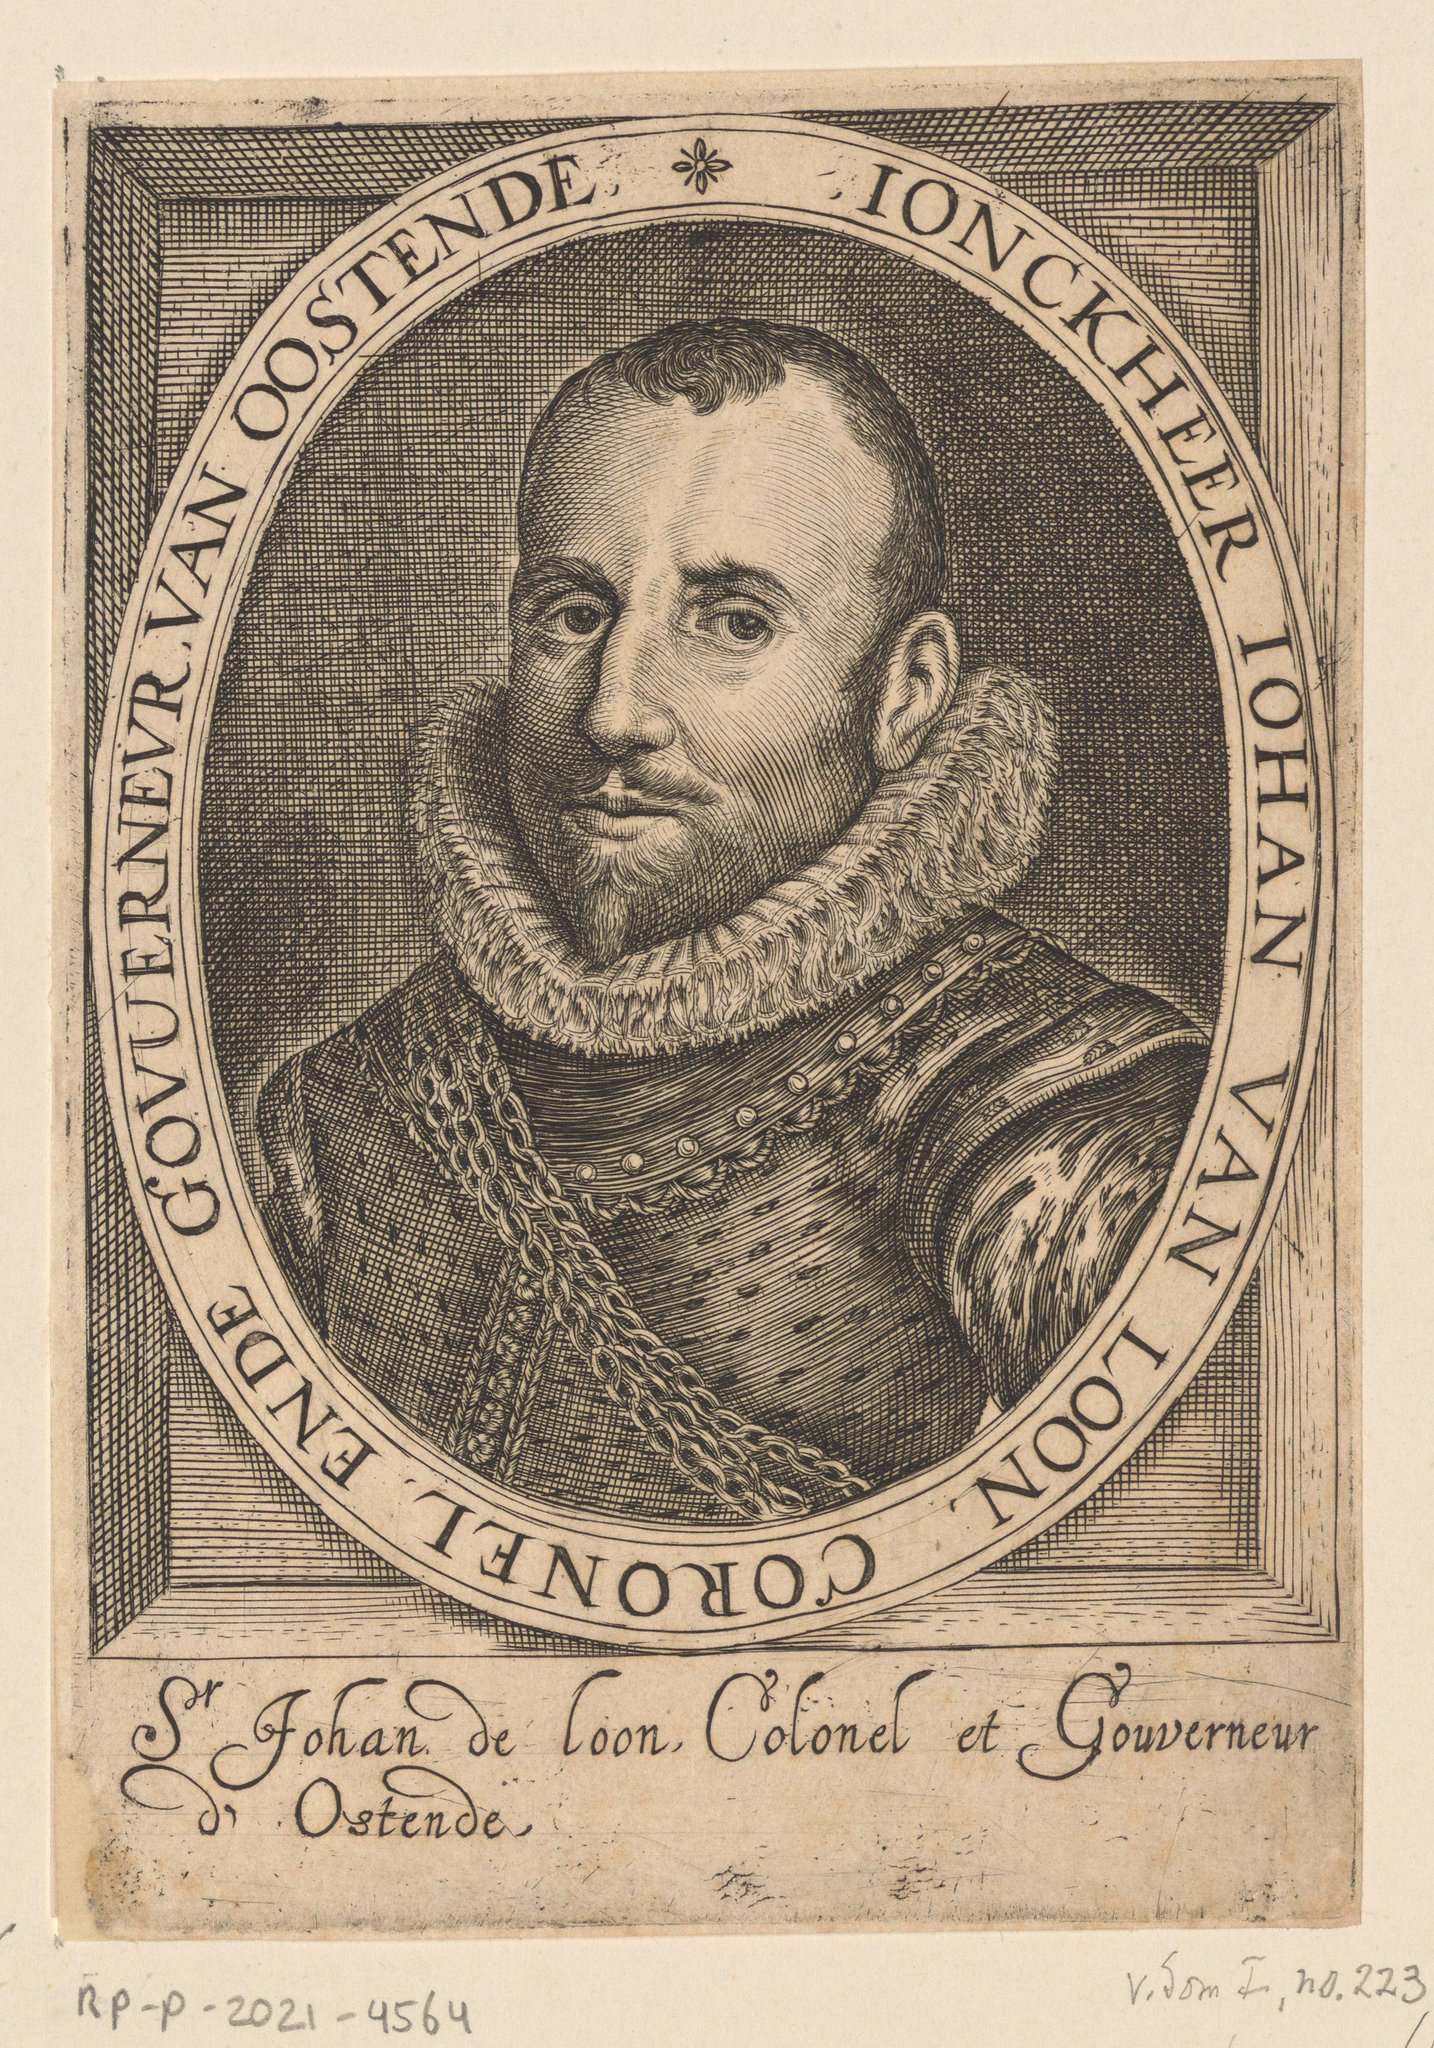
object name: print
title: Portret van Johan van Loon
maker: Anonymous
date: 1621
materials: paper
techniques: engraving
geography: northern netherlands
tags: historical persons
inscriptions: collector's mark: Lugt 2228, collector's mark: Lugt 964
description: Prent waarschijnlijk uit: Fleming, Philippe. Oostende: vermaerde, gheweldighe, lanckduyrighe, ende bloedighe belegheringhe (...). Den Haag: Aert Meuris, 1621.